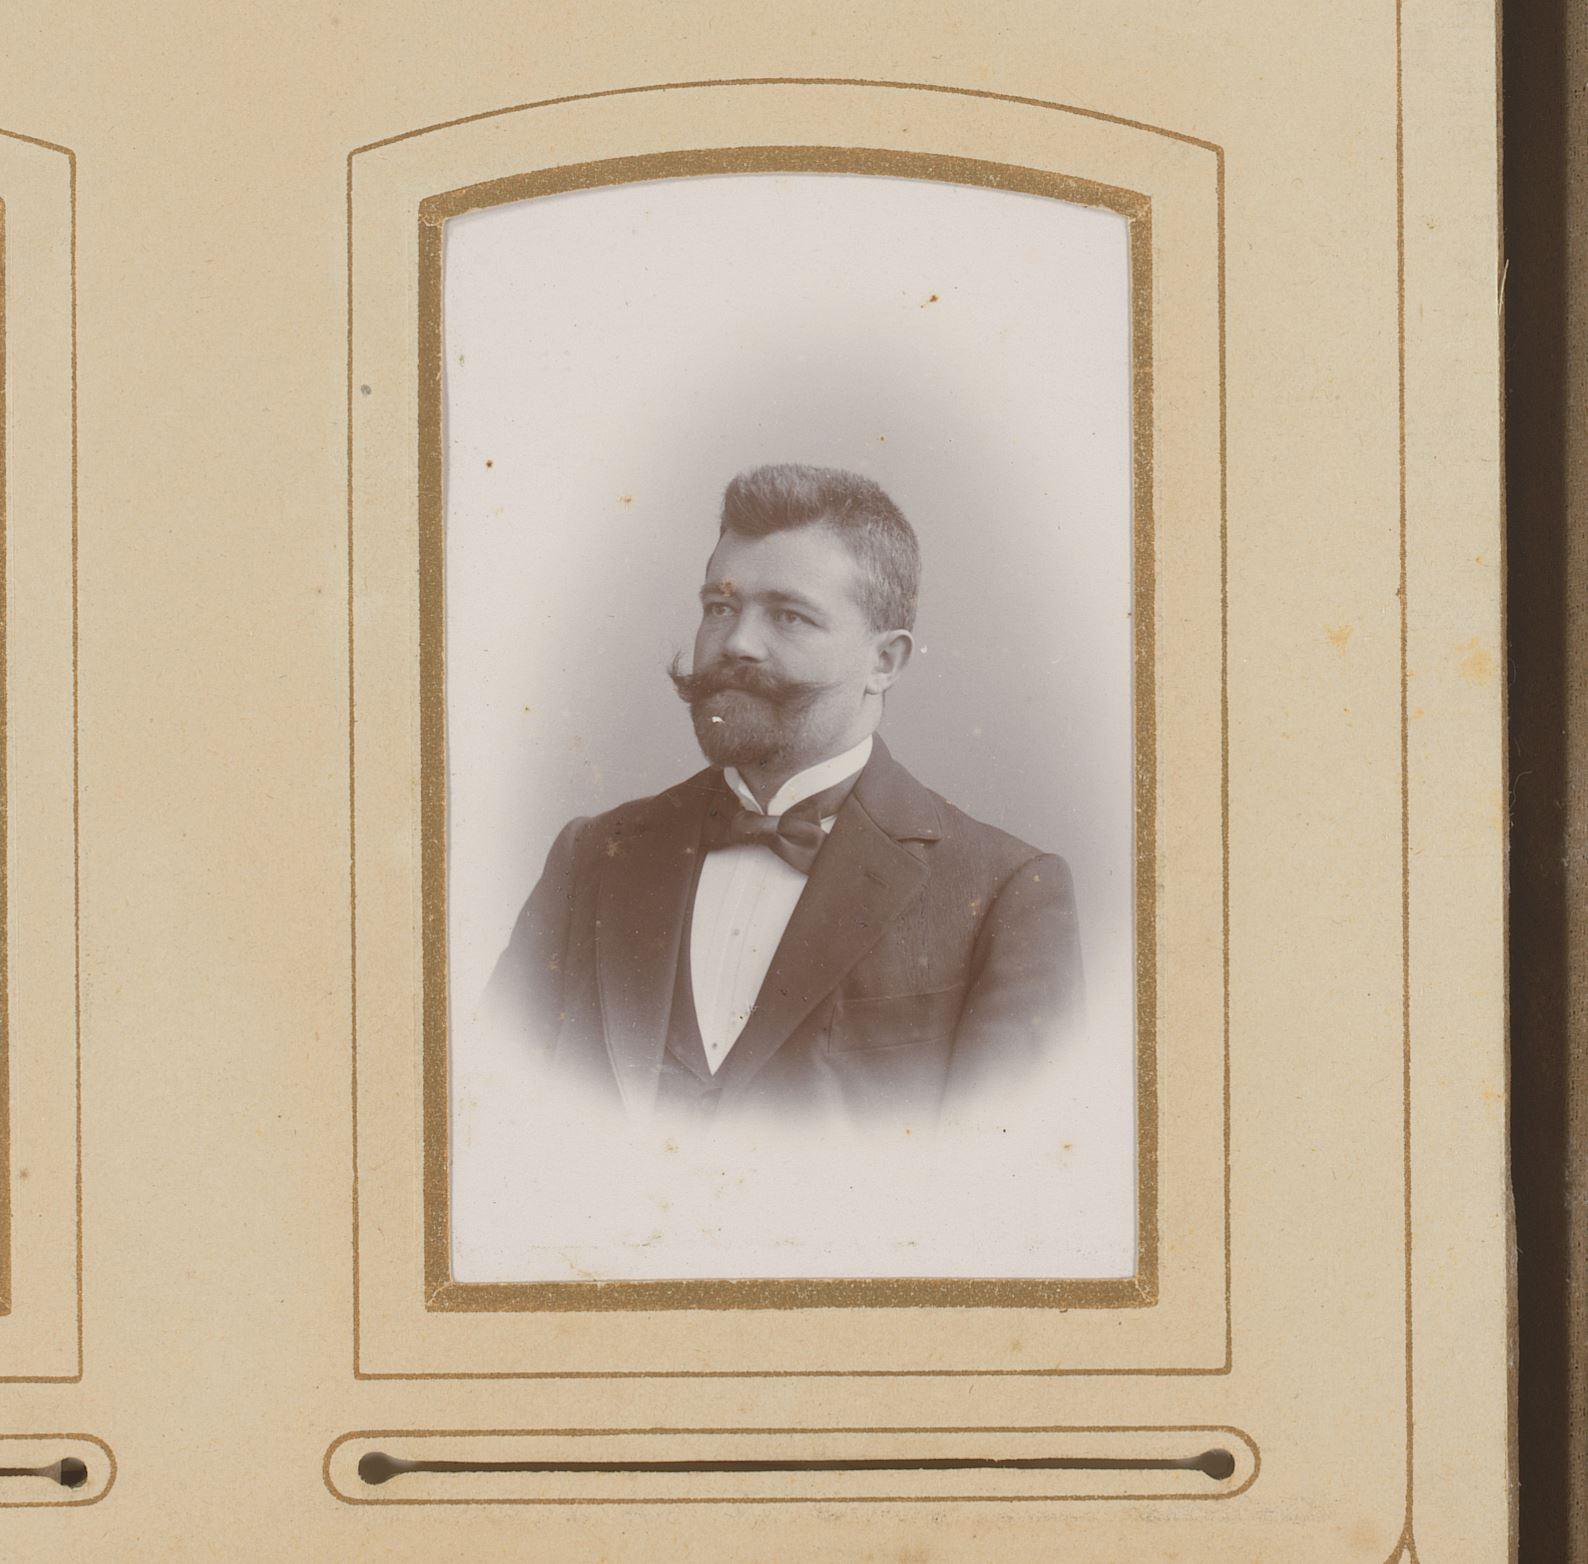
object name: photograph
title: Portret van een man met snor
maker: Anonymous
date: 1880-1910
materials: cardboard, photographic support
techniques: collodion silver print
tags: moustache, historical persons